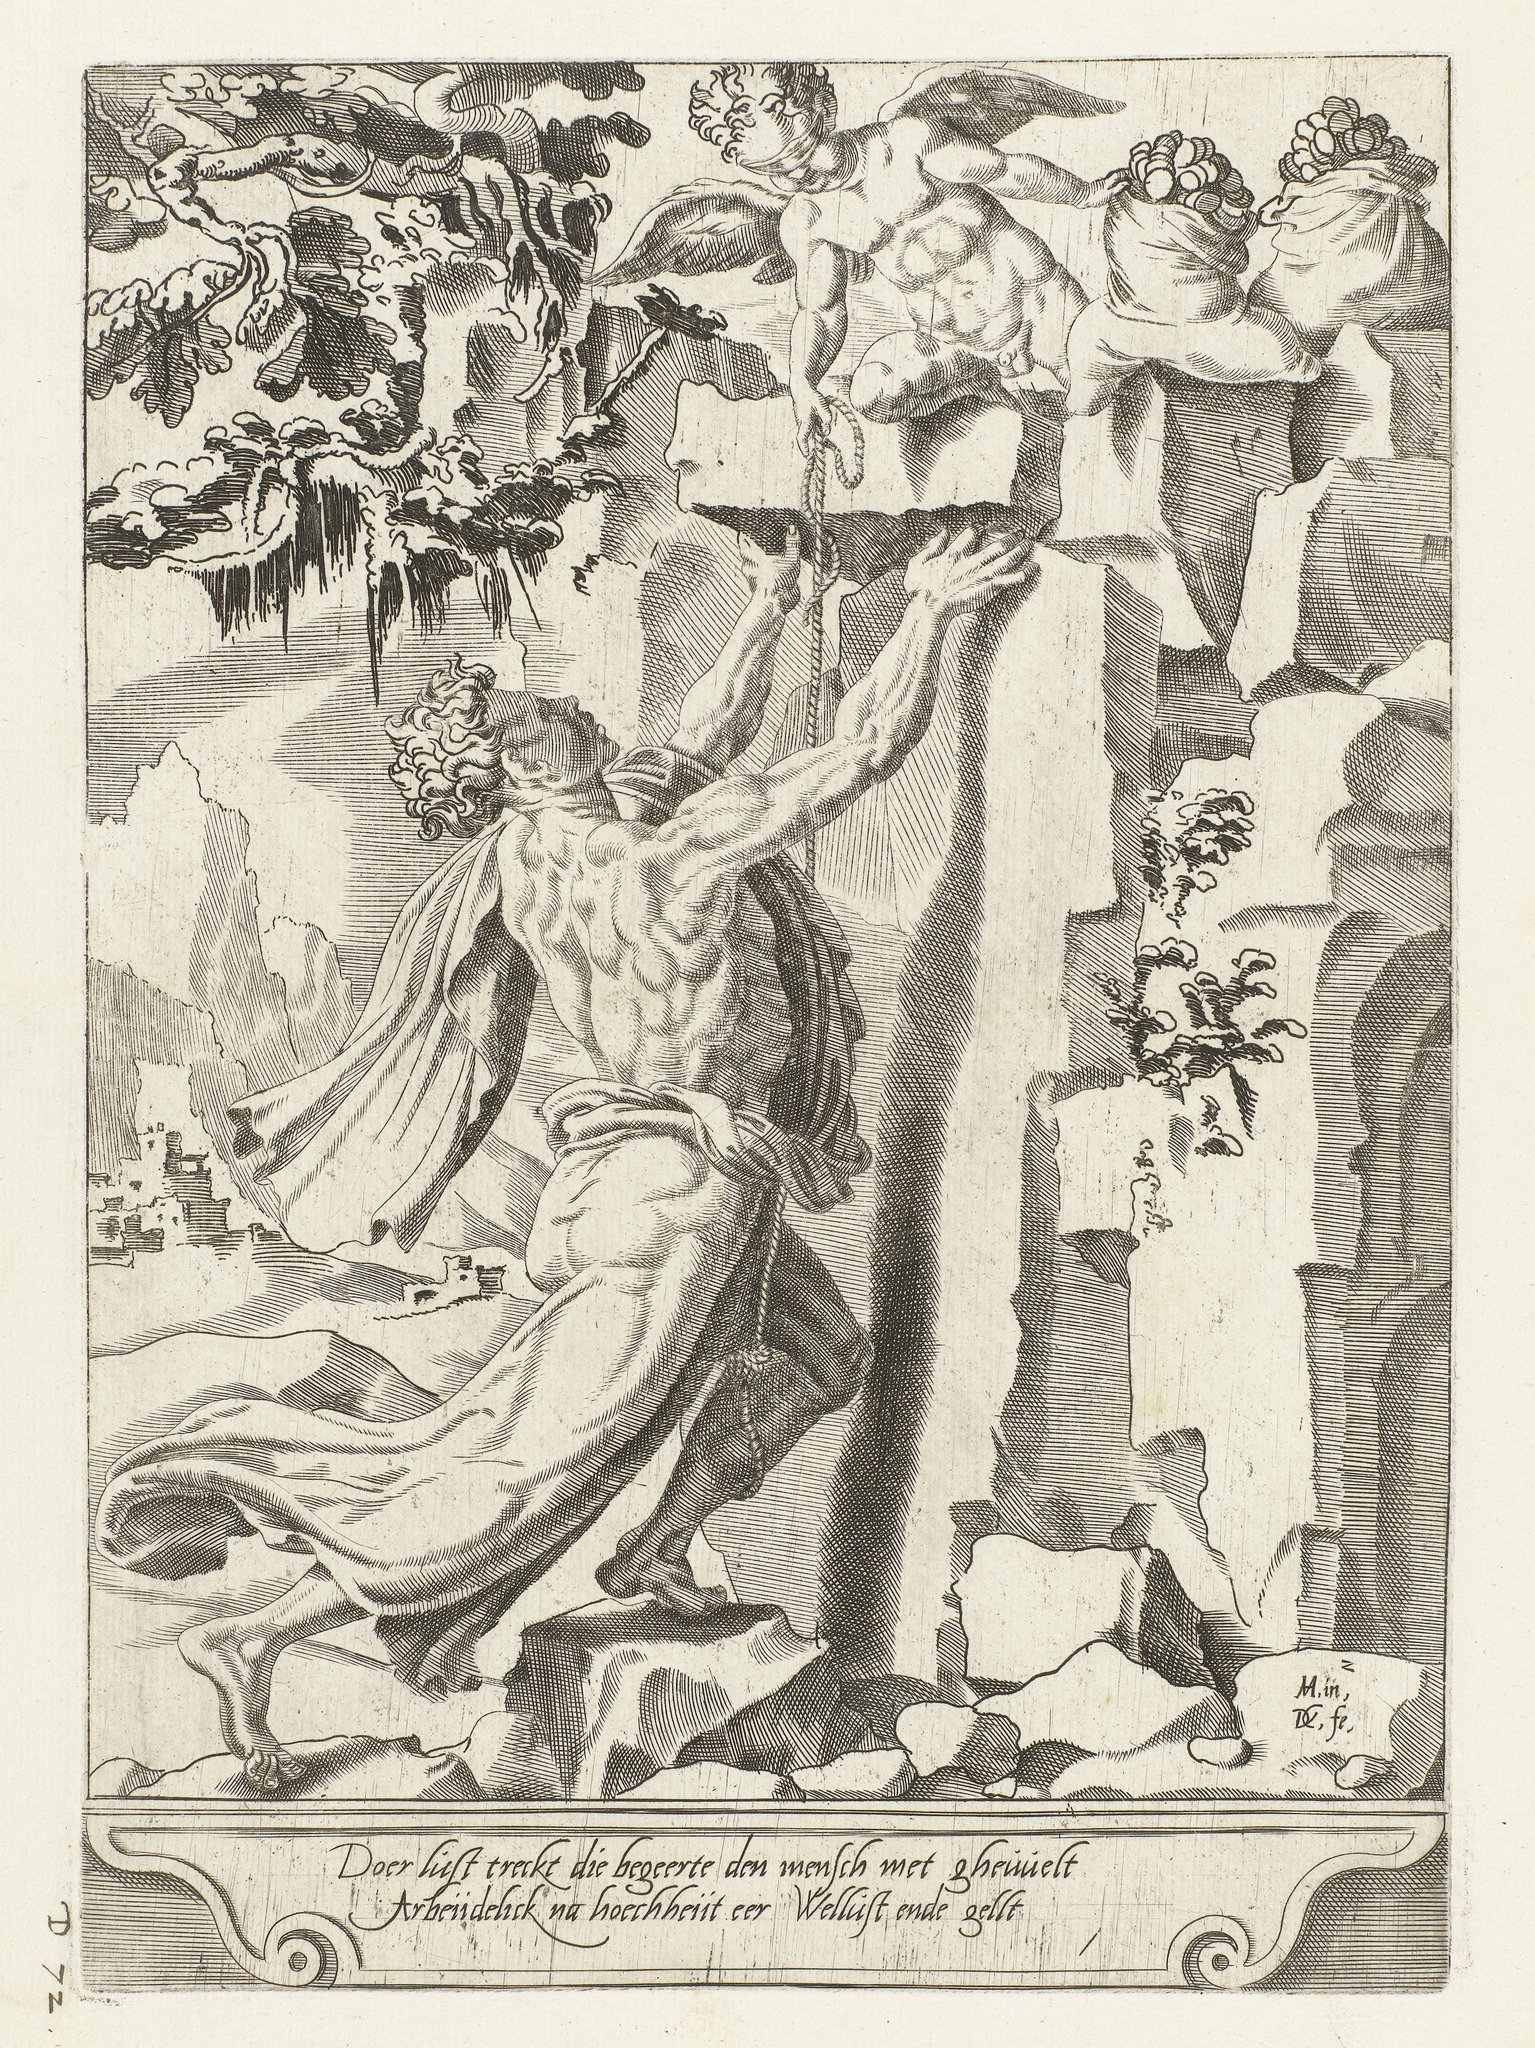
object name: print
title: Door Blinde Begeerte en de hoop op rijkdom wordt de mens meegesleept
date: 1550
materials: paper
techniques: engraving, etching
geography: haarlem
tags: purse, money-bag, desire; 'desiderio' (ripa), personifications ~ the life of man, tools, aids, implements ~ crafts and industries: rope, attributes of cupid: blindfold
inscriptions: collector's mark: Lugt 2760, collector's mark: Lugt 2228, number: ‘D. 71’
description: De geblinddoekte Cupido (Blinde begeerte) zit bovenop een rots. In zijn handen een touw waaraan de Mens is geketend. Deze probeert de rotswand op te klimmen om Cupido en twee zakken met geld te bereiken. In een cartouche onderaan de prent een Nederlands onderschrift op rijm. De prent maakt deel uit van een vierdelige serie over de nutteloosheid van hoop op geld en andere wereldlijke zaken.